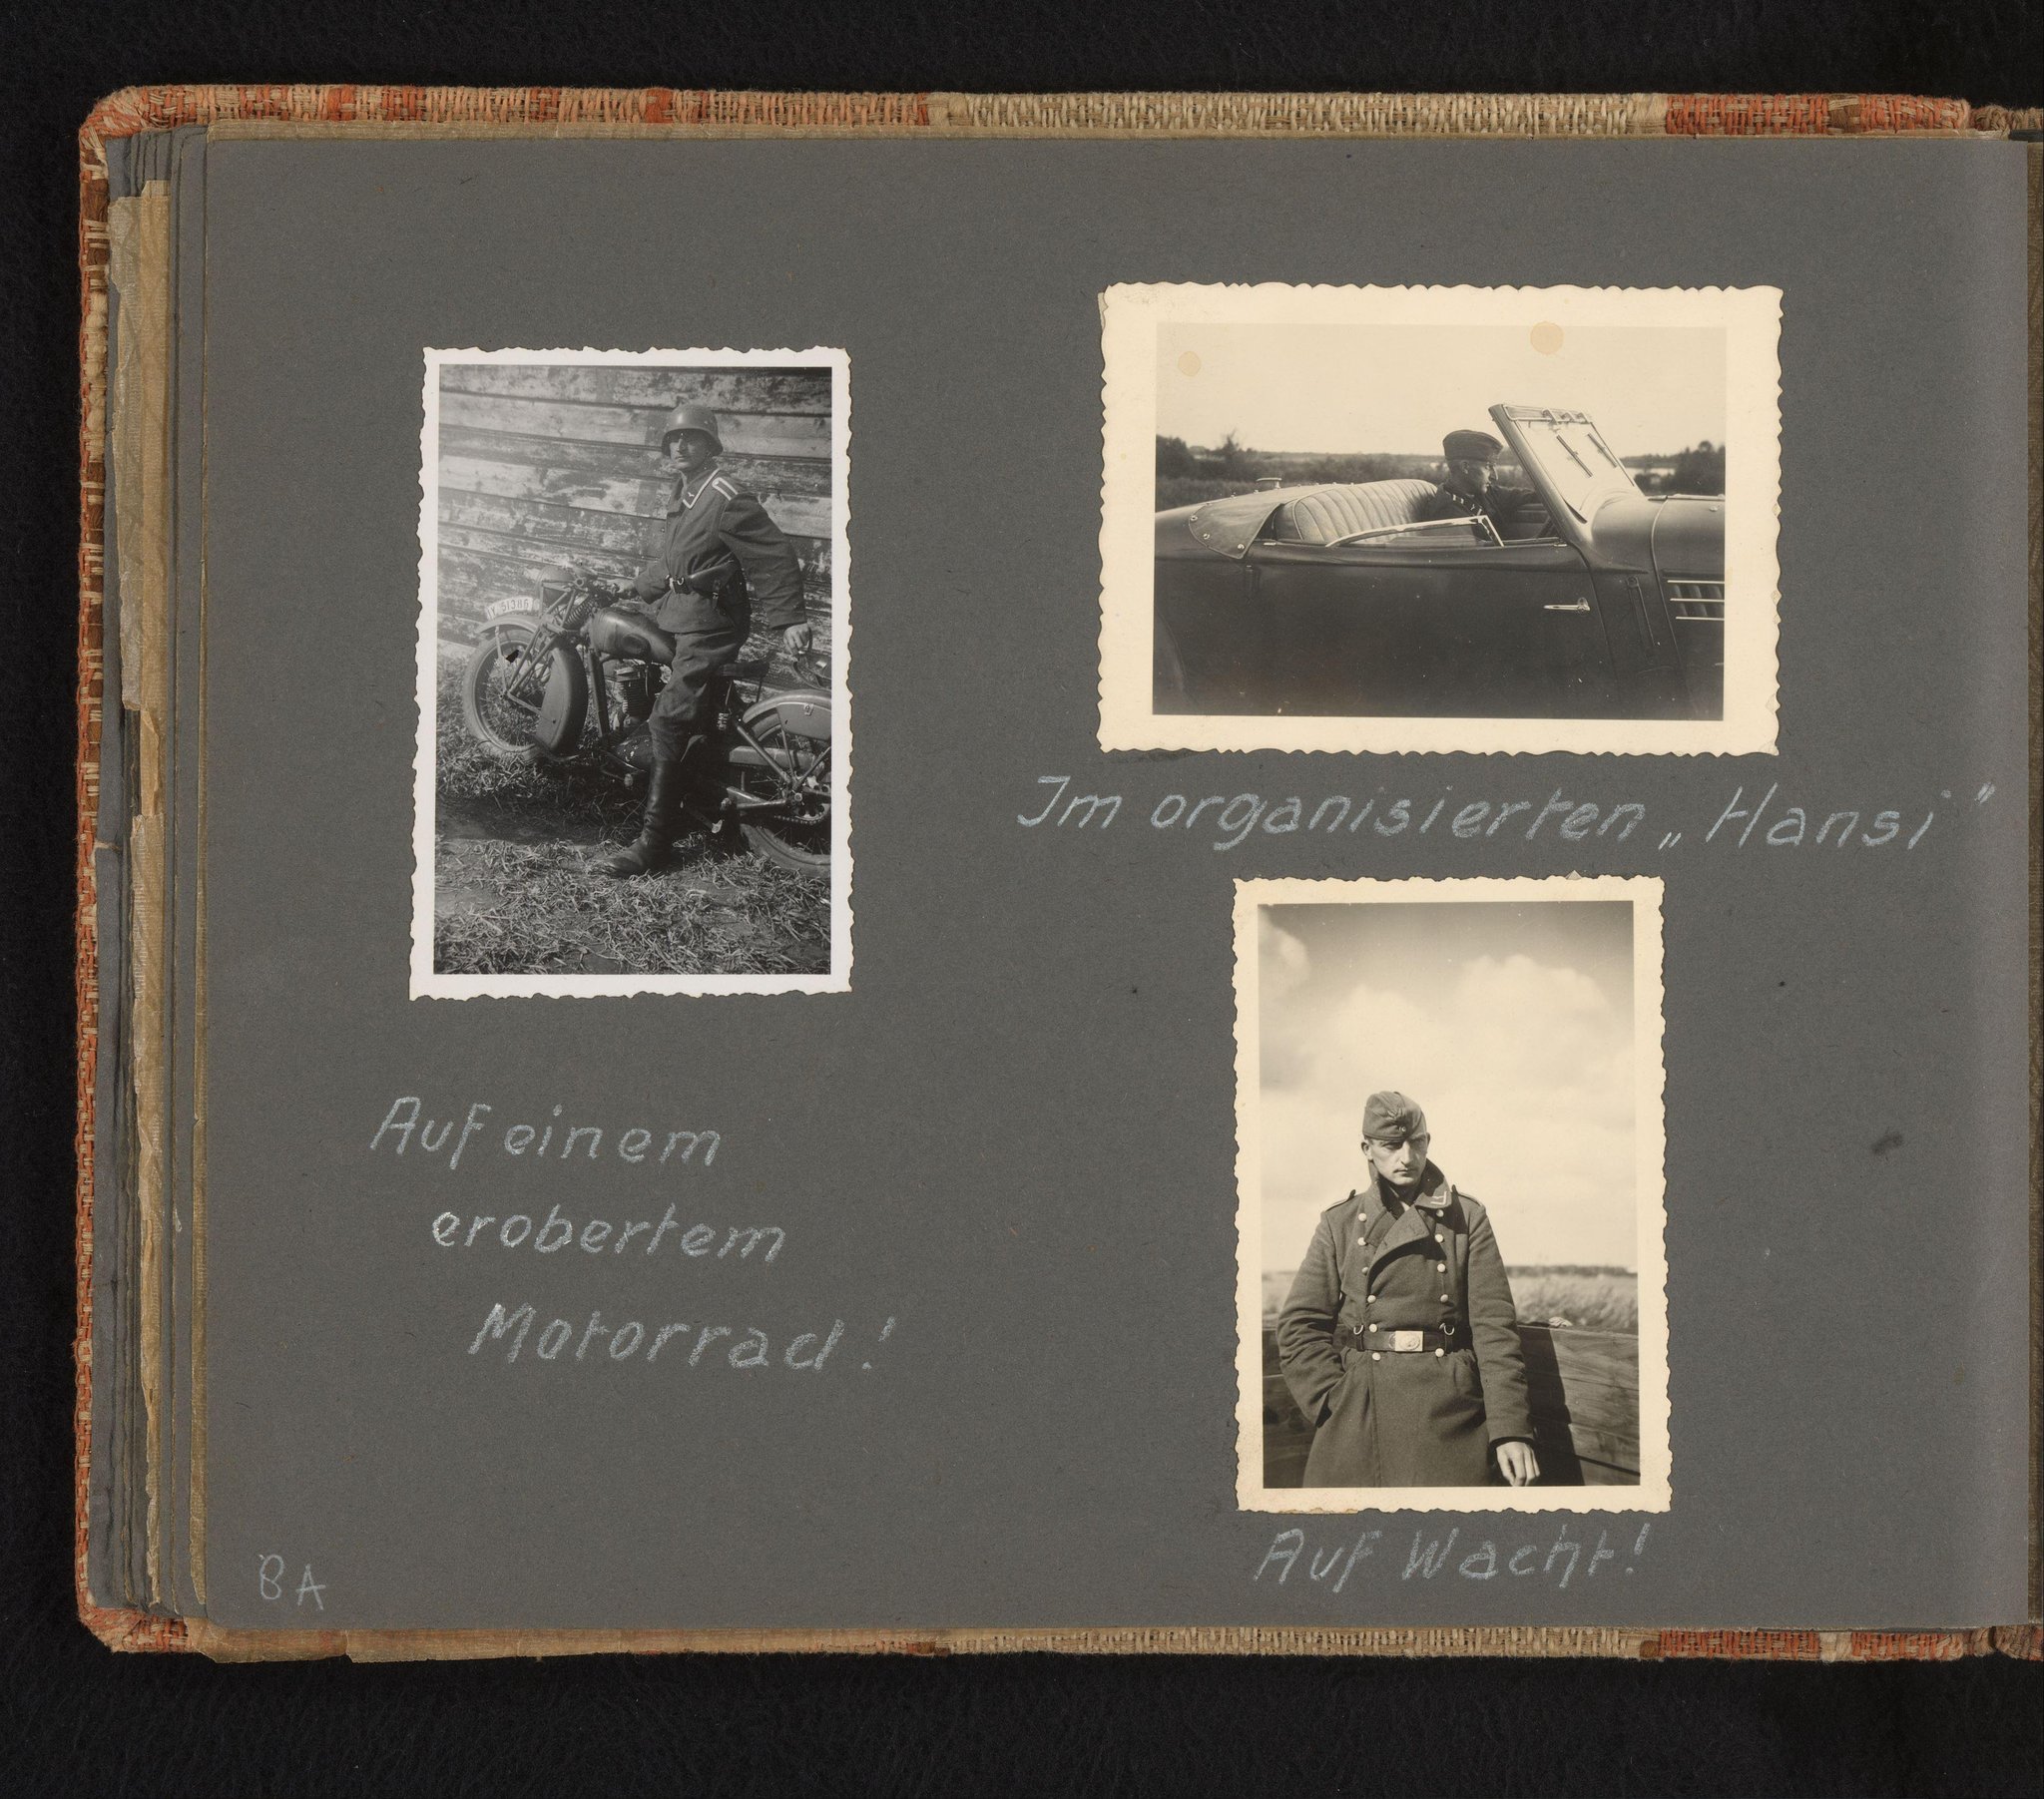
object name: photograph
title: Heinemann in Holland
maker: Anonymous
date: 1940-1941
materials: paper, photographic support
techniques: gelatin silver print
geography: netherlands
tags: military service, occupation ~ war, netherlands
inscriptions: inscription: ‘Auf einem erobertem Motorrad! / Im organisierten "Hansi" / Auf Wacht!’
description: Albumblad met drie foto's van Heinemann bij een veroverde Nederlandse motorfiets, in een auto en op wacht. Onderdeel van het fotoalbum 'Kriegszeit in Holland' over de diensttijd in Nederland van Hans Heinemann van een Flak Regiment van de Luftverteidigungskommando van de Luftwaffe.